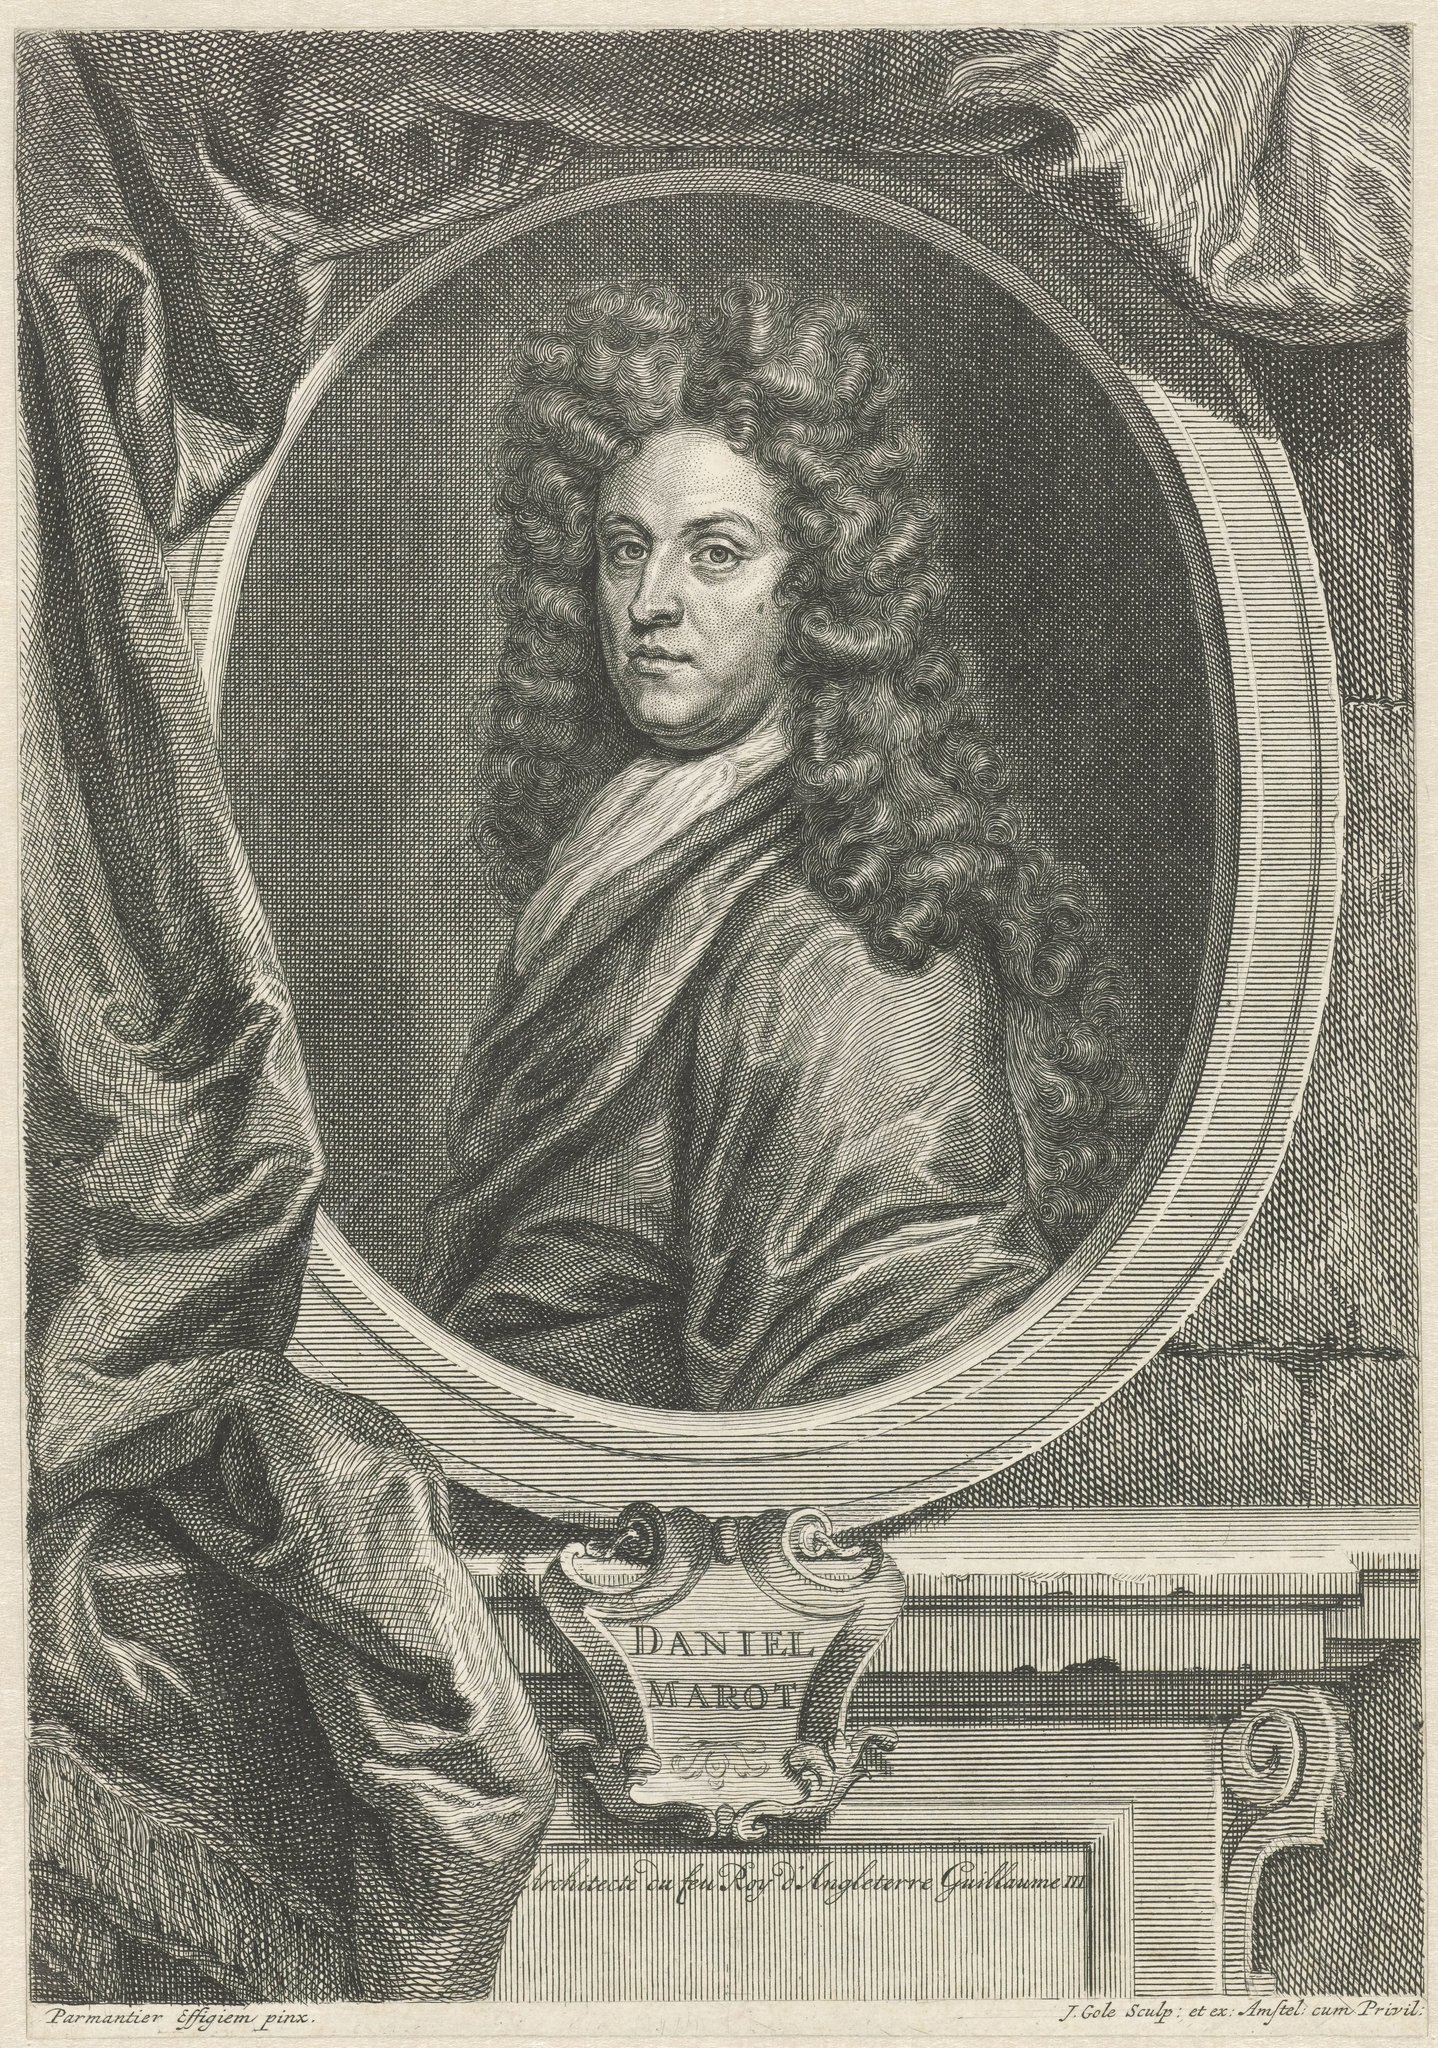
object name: print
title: Portret van Daniël Marot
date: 1689-1724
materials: paper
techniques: engraving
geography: amsterdam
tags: paris, the hague, print maker, draughtsman, daniël marot (i)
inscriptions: collector's mark: Lugt 2760, collector's mark: Lugt 2228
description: Portret in ovale lijst van Daniël Marot, een Nederlandse architect en prentmaker. Ten halven lijve naar links. Rondom het portret een draperie. De prent heeft een Frans onderschrift.